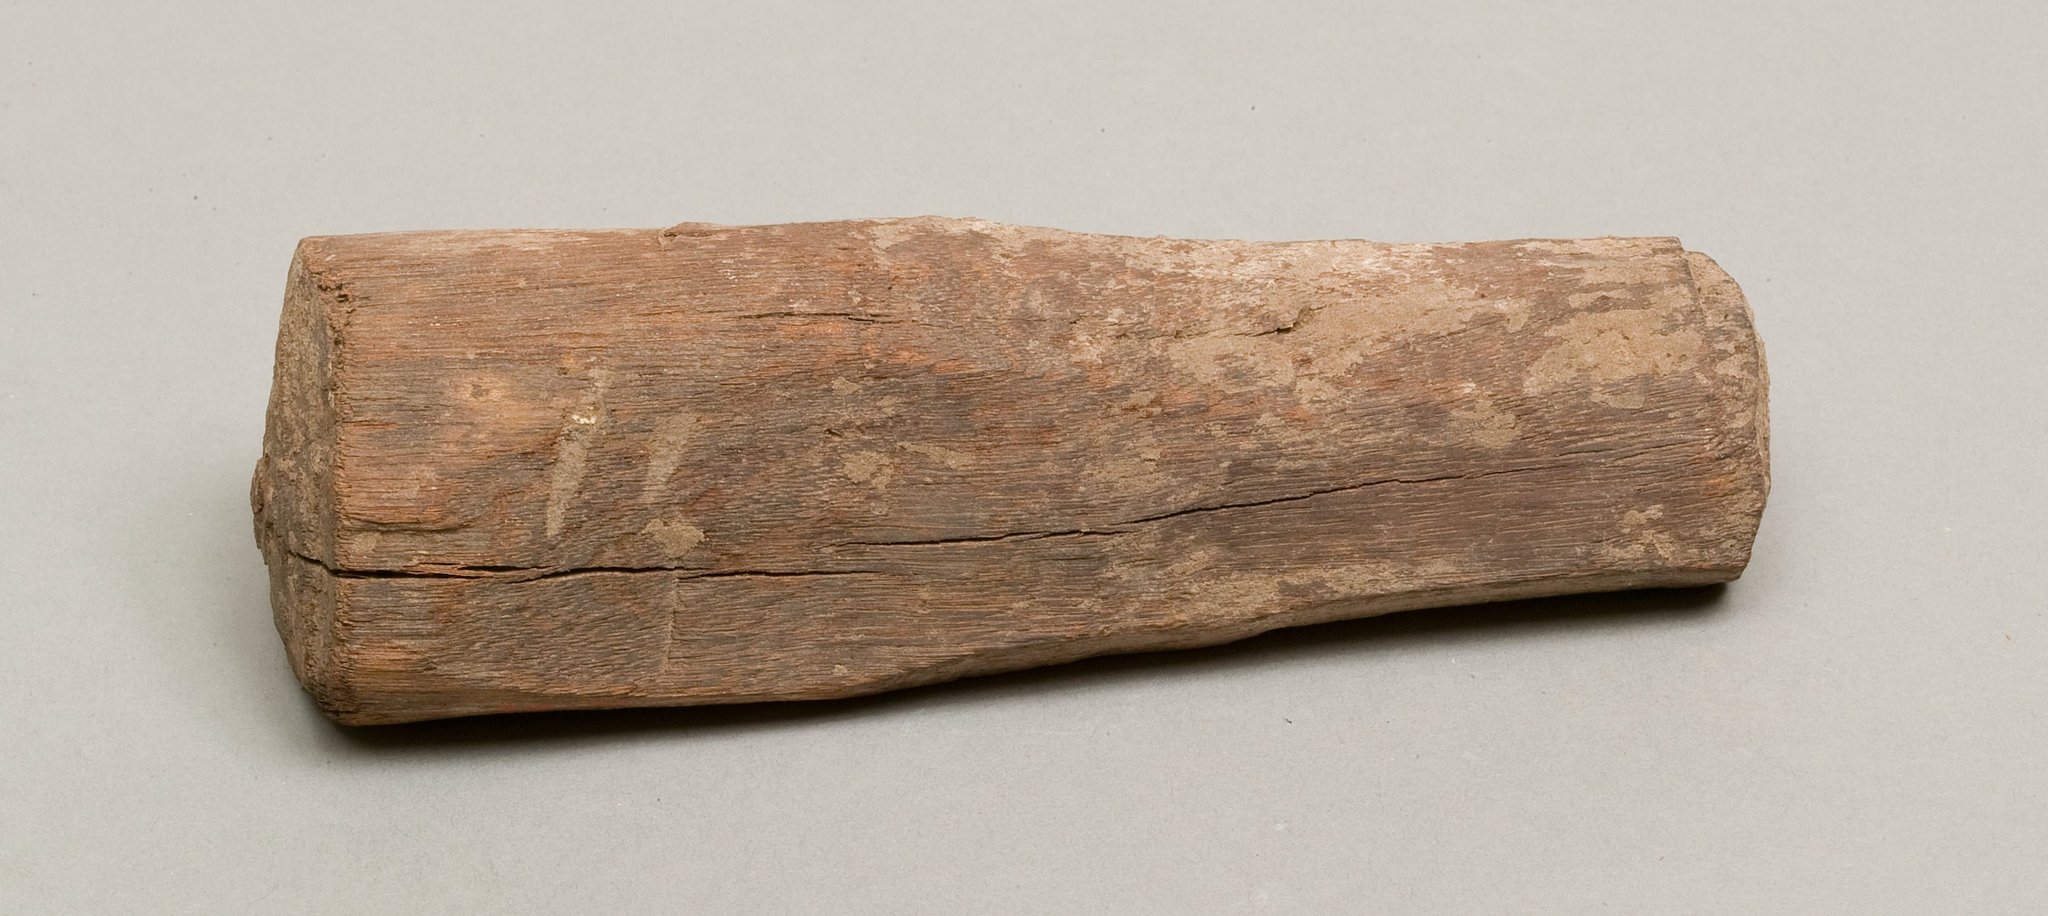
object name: peg, to hold end beam of loom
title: Loom equipment (?)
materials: wood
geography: egypt